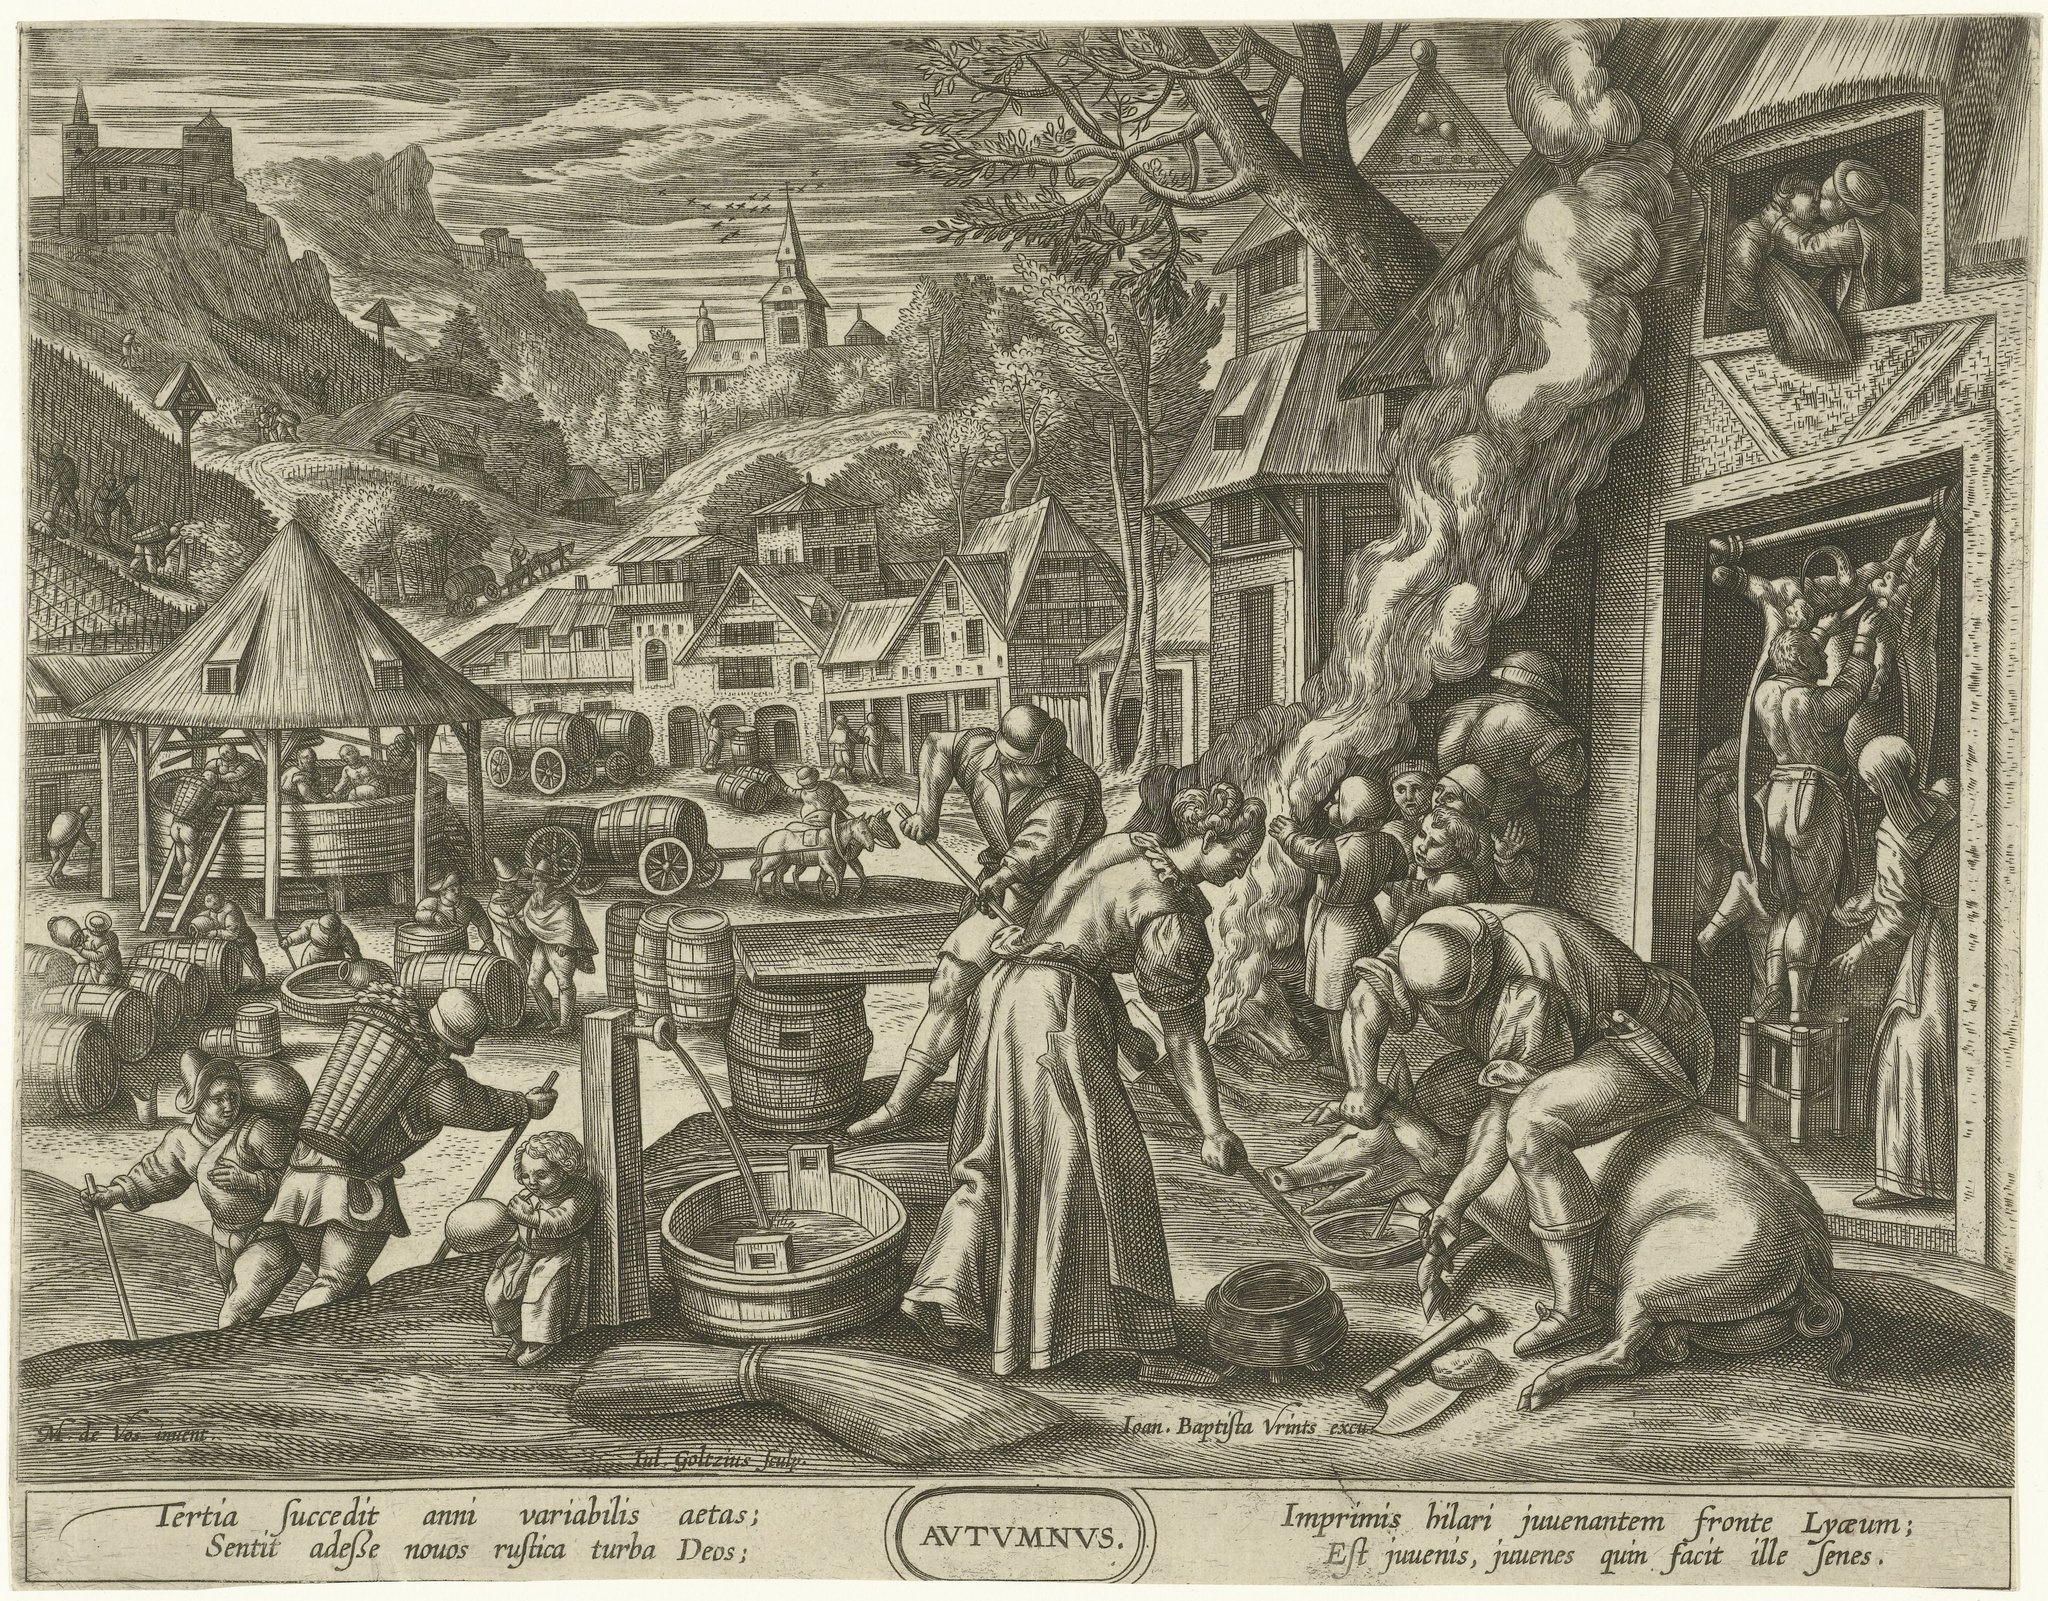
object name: print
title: Herfst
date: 1575-1595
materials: paper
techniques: engraving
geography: antwerp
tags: autumn ~ human activities (the four seasons of the year), autumn, fall, 'autumnus'; 'autunno' (ripa)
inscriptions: collector's mark: Lugt 240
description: Centraal het slachten van varkens en het roken en pekelen van het vlees. Op de achtergrond de druivenpluk en het maken en tonnen van wijn. Mannen, vrouwen en kinderen plukken druiven en persen ze. Daarna wordt de wijn in tonnen gegoten en weggebracht. De prent heeft een Latijns onderschrift en maakt deel uit van een serie met als onderwerp de vier seizoenen.